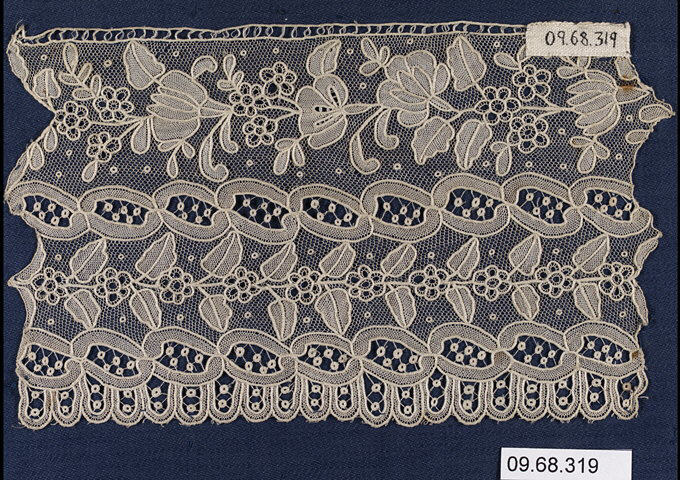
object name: fragment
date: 1801-1900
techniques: lace